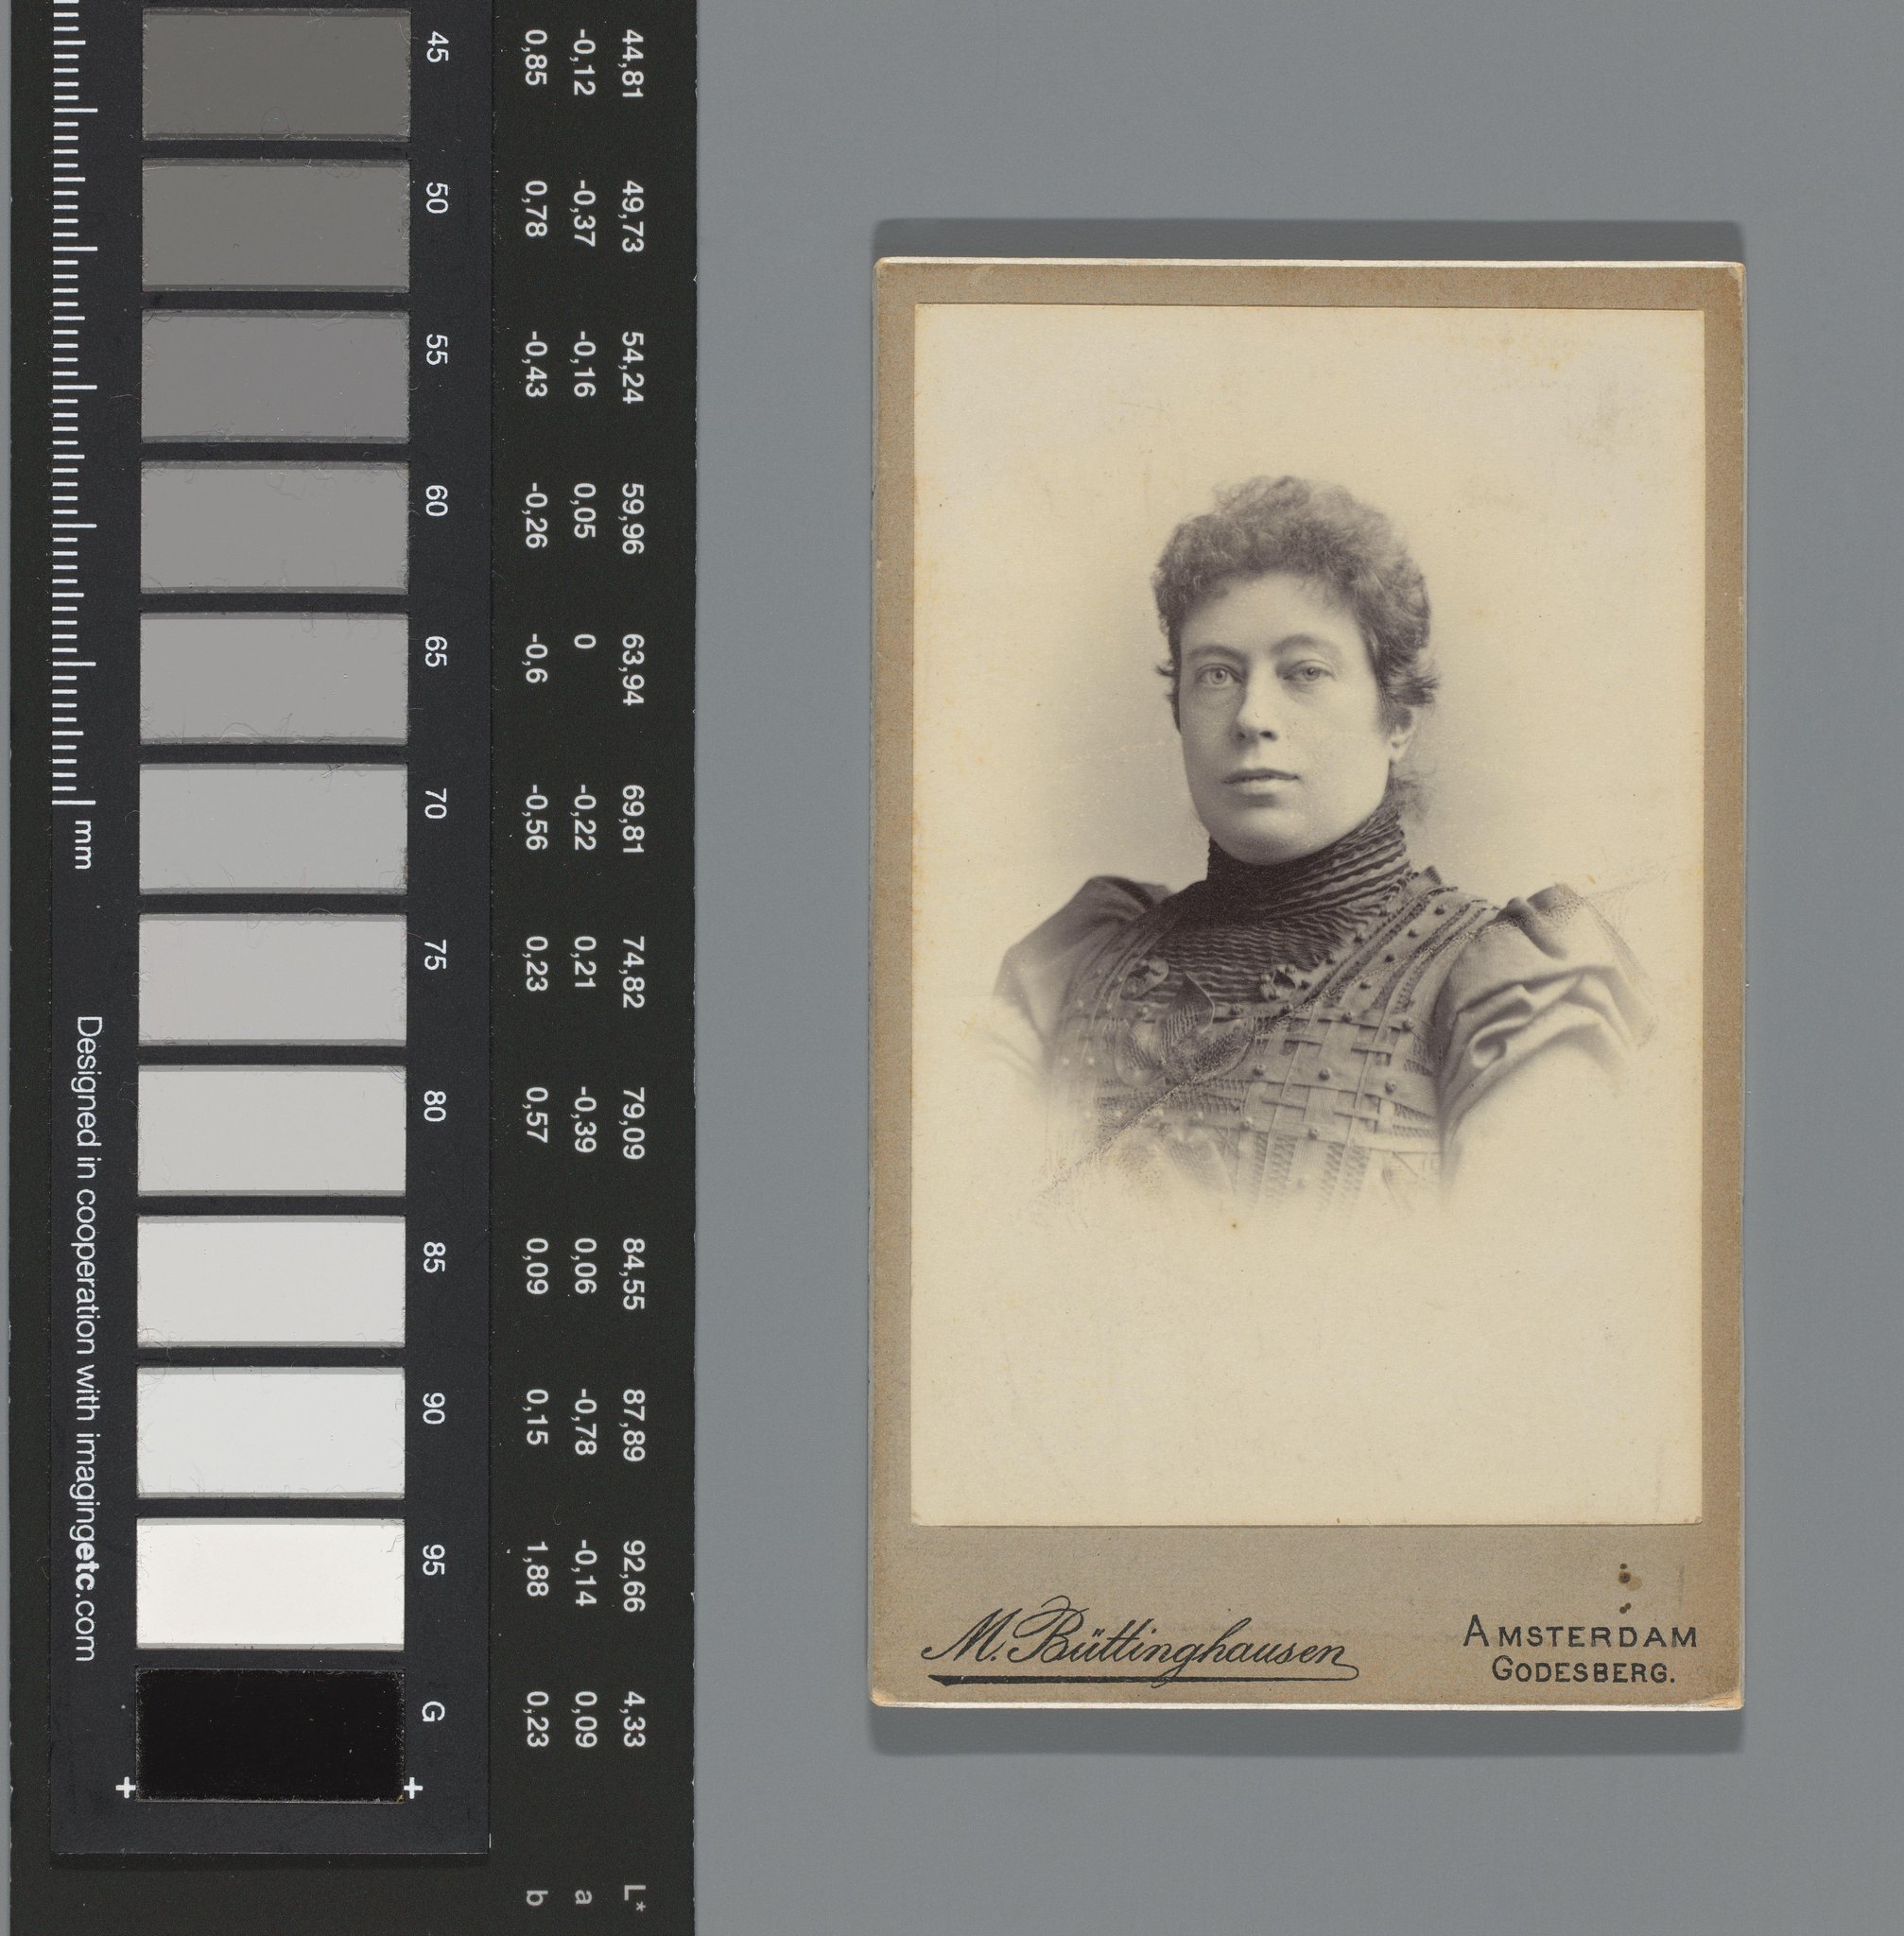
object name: carte de visite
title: Portret van mevrouw van der Mey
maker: max büttinghausen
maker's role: fotograaf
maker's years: 1847-1906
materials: cardboard, photographic support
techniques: gelatin silver print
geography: amsterdam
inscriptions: inscription: ‘mevr. Van der Mey’